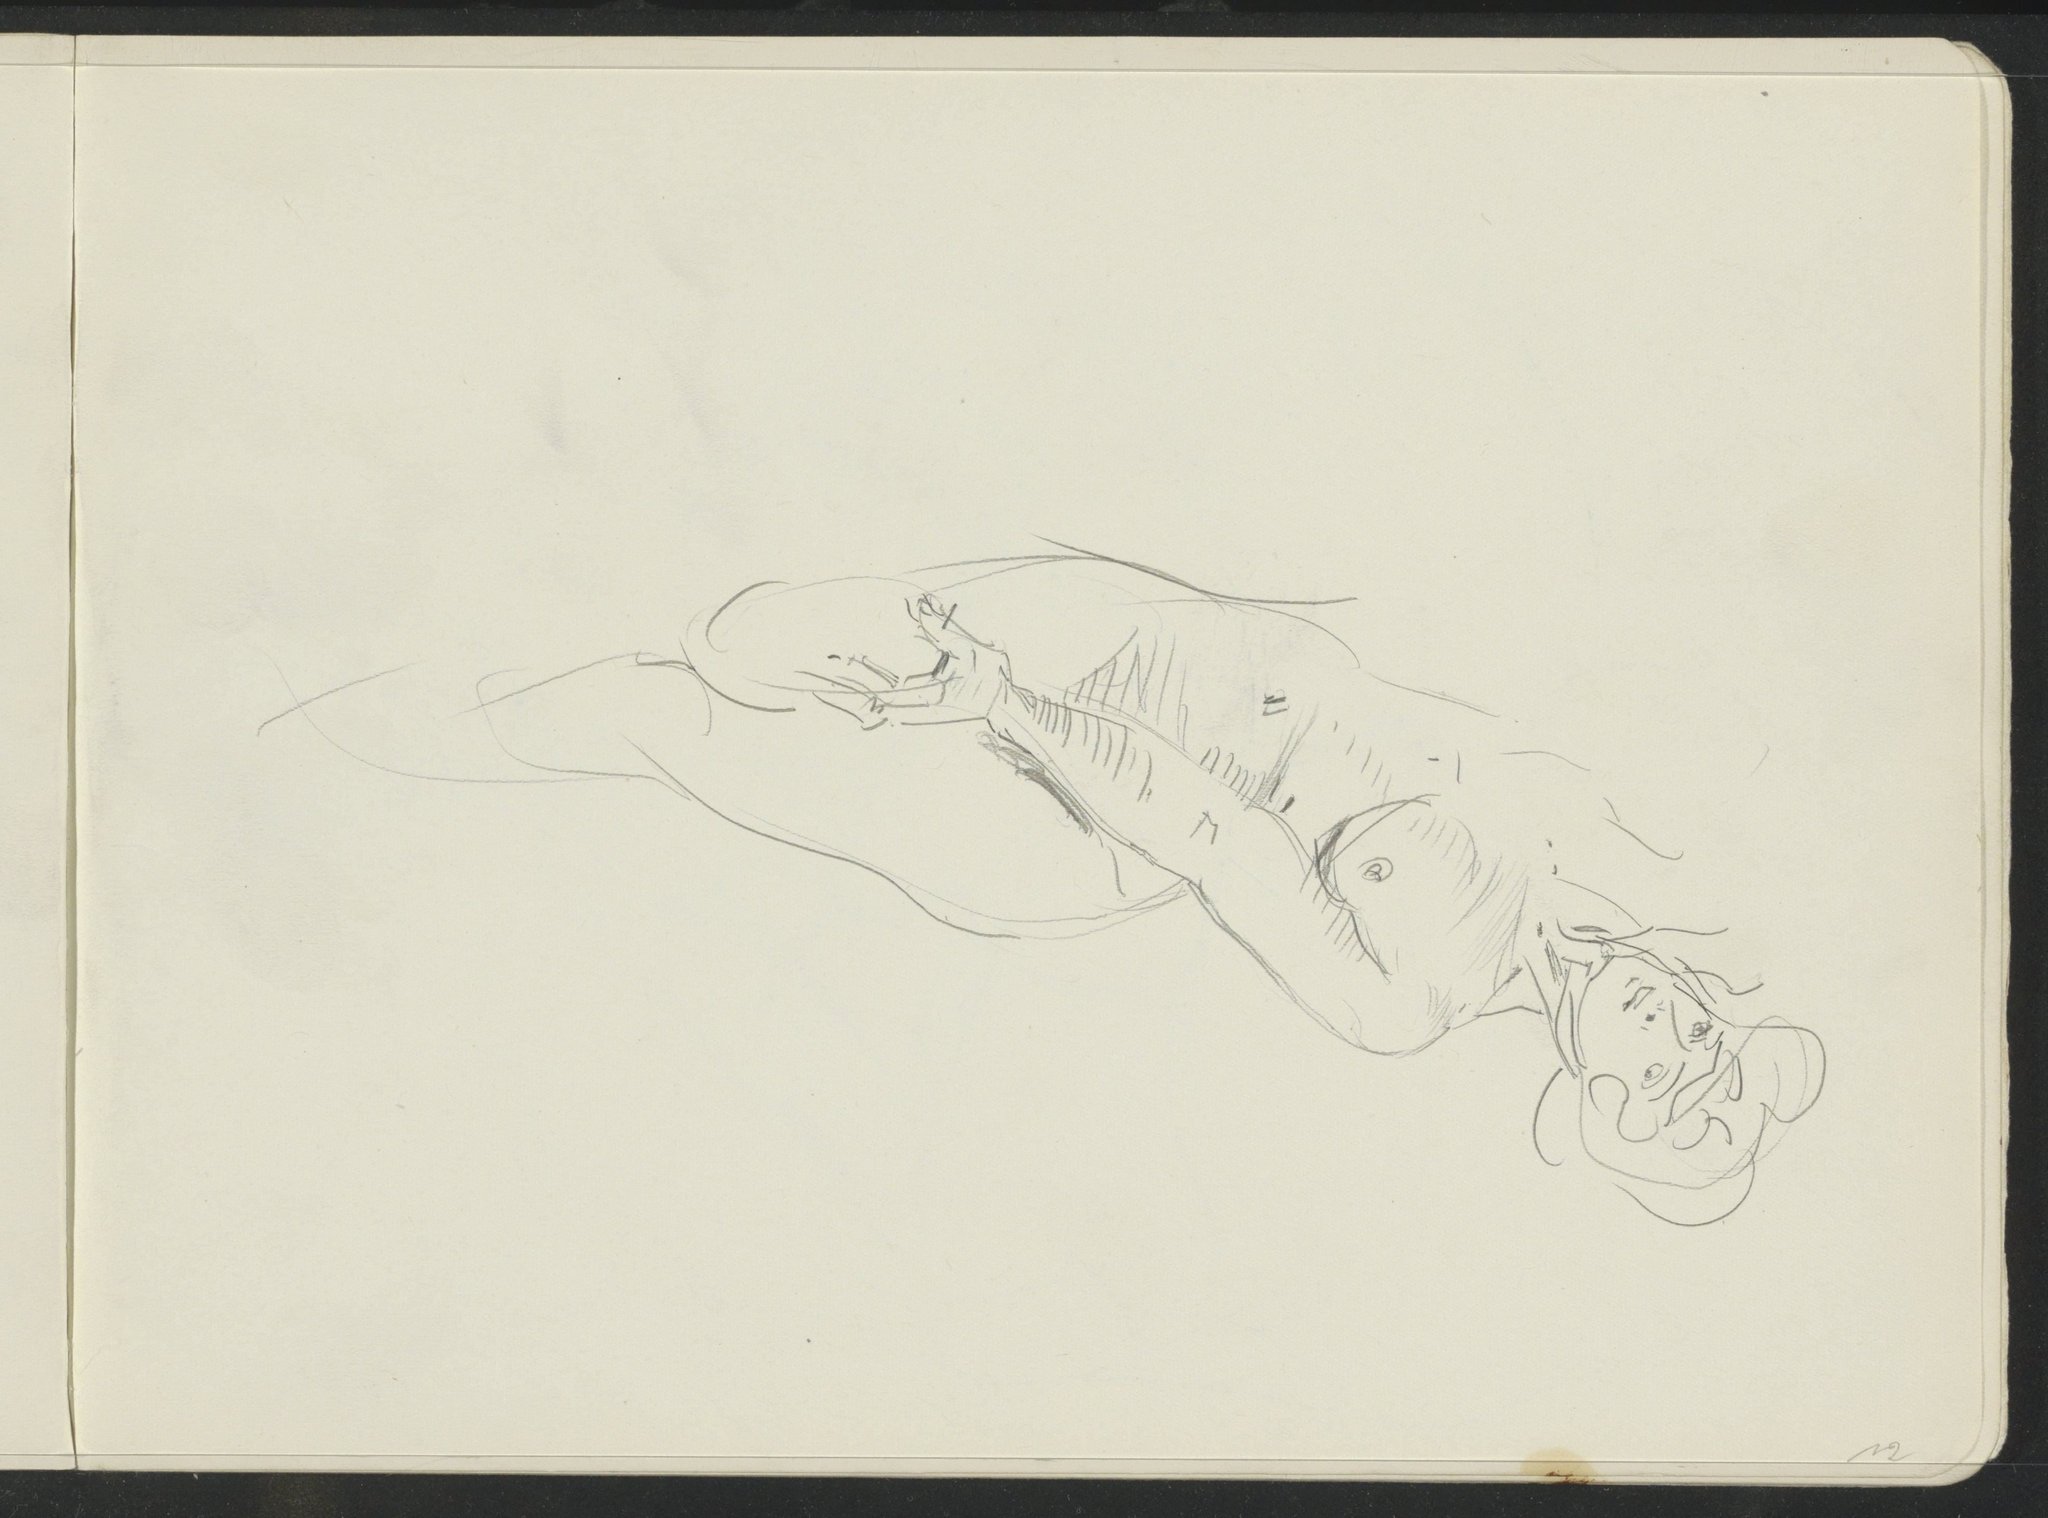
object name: sketchbook leaf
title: Liggend vrouwelijk naakt, leunend op een arm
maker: isaac israels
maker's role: draughtsman, painter, print maker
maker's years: 1865-1934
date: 1915-1934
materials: paper, pencil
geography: the hague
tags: lying figure - aa - female human figure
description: De andere hand ligt op haar bovenbeen. Blad 12 recto uit schetsboek XV met 22 bladen.